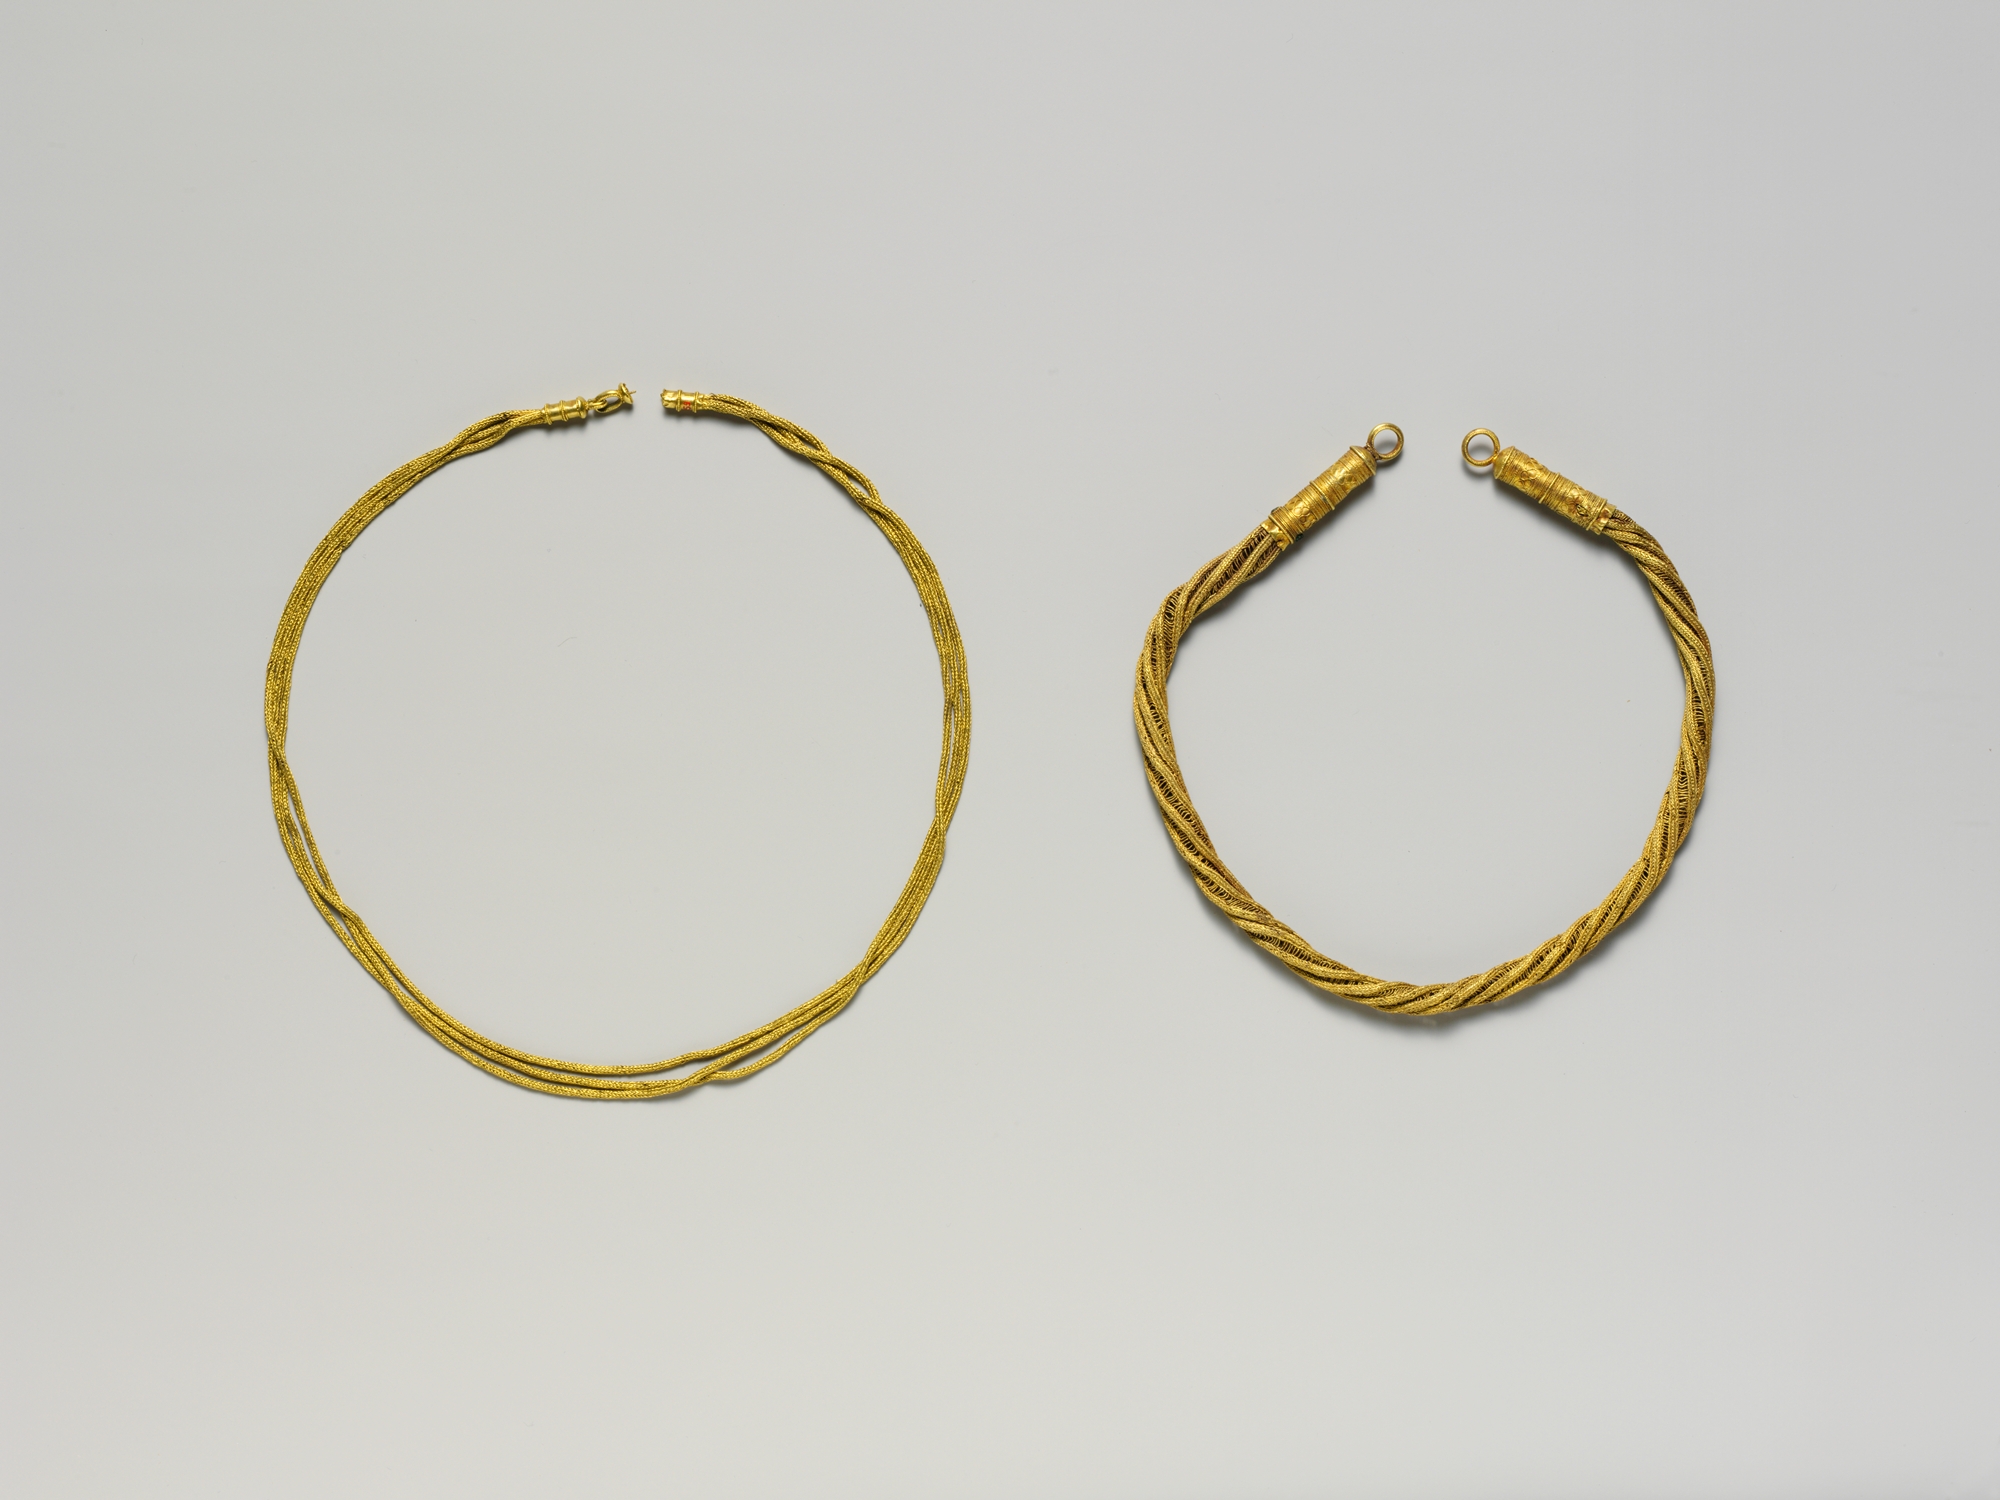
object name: necklace or collar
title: Gold chain in three strands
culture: etruscan or roman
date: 301-400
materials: gold